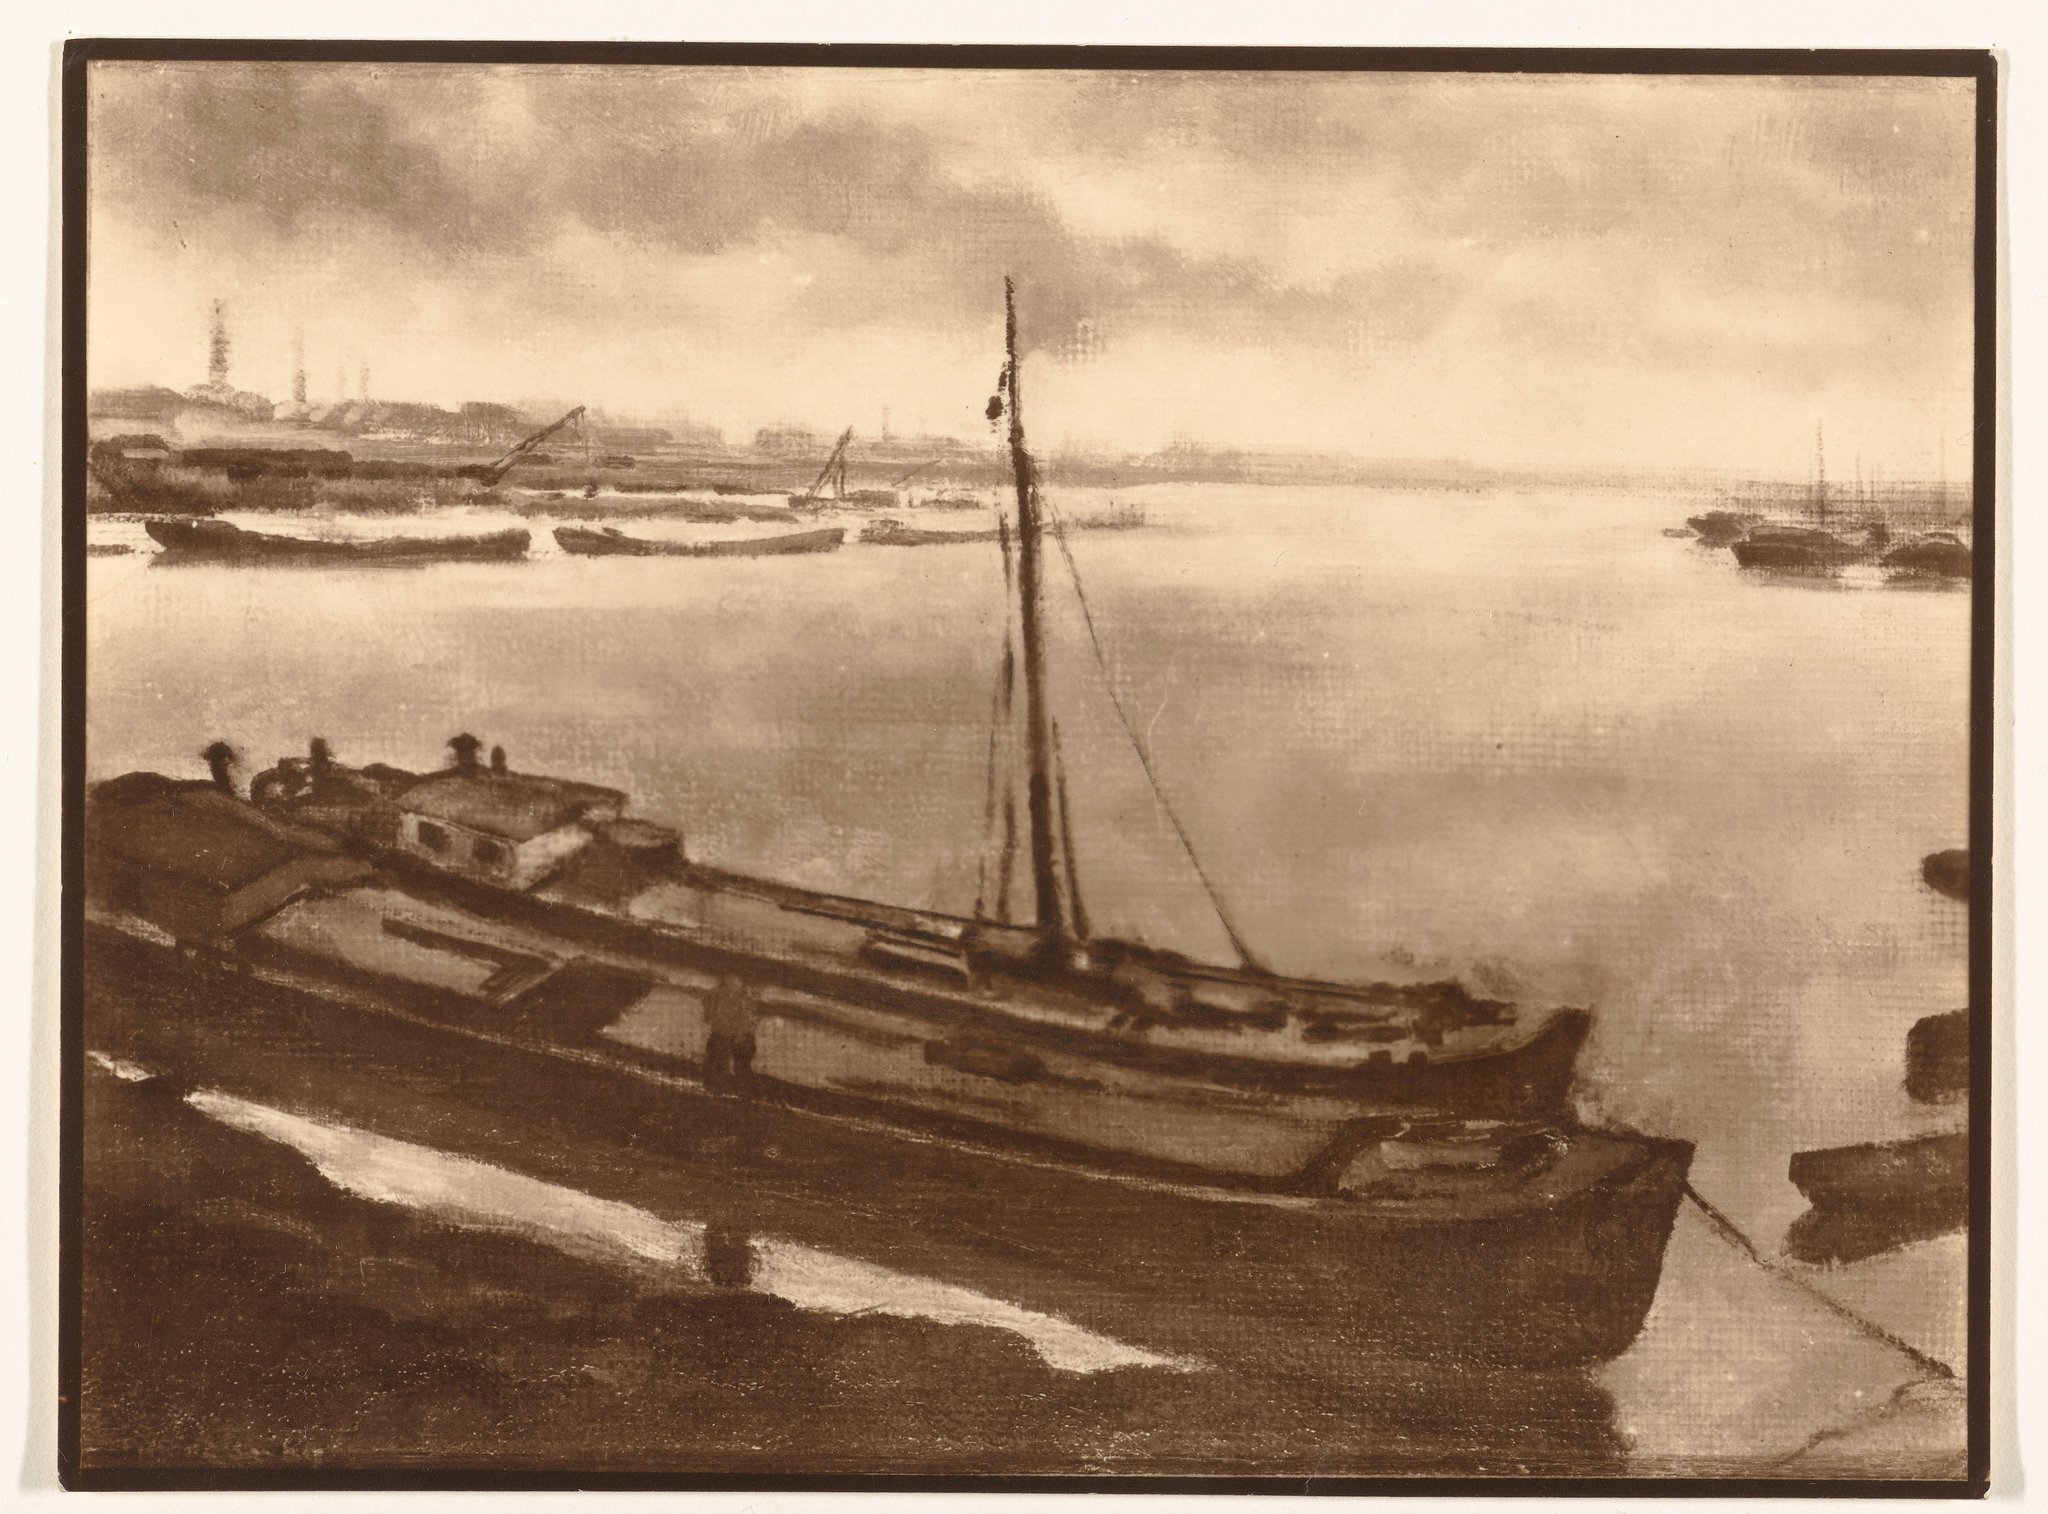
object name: photograph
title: Fotoreproductie van een schilderij (havengezicht) door Han van der Kop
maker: adriaan bijl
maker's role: fotograaf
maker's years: 1874-1967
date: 1933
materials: paper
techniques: gelatin silver print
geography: amsterdam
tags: harbour, ships (in general), picture, painting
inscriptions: annotation: ‘reproductie van nagelaten werk van Han van der Kop’